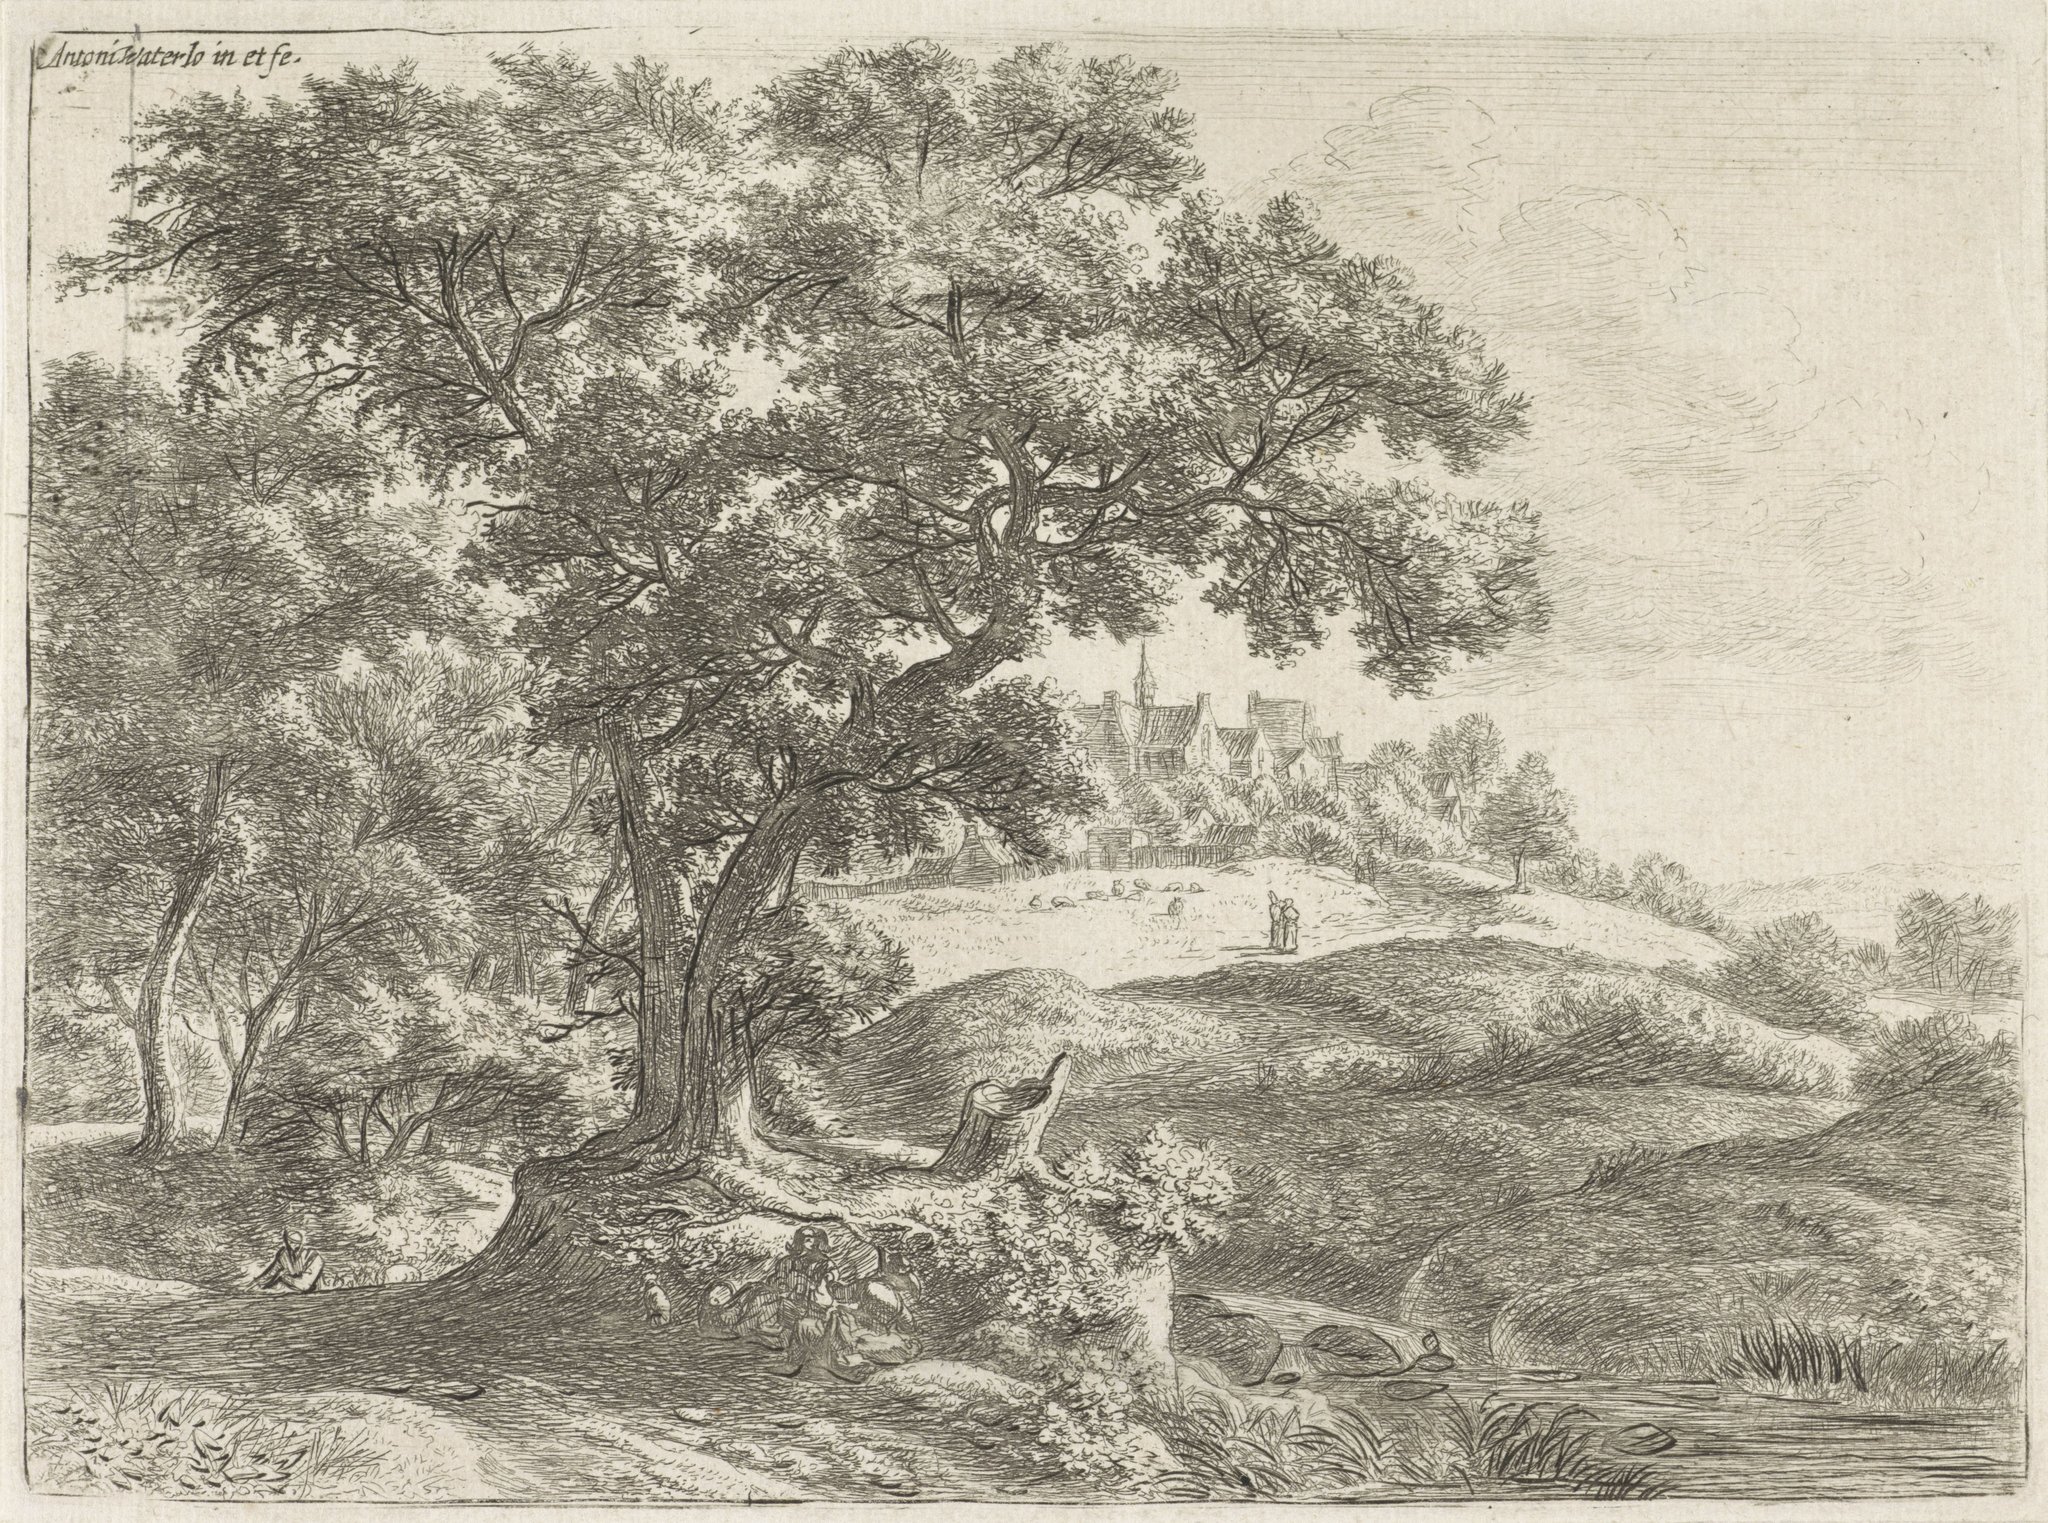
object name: print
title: Landschappen, serie A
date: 1630-1663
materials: paper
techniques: etching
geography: amsterdam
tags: low hill country, village, forest, wood, brook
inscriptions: collector's mark: Lugt 2228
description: Links loopt een wandelaar over een bospad in een glooiend landschap. Rechts stroomt een beek. Rechts in de verte ligt een dorp op een heuvel.